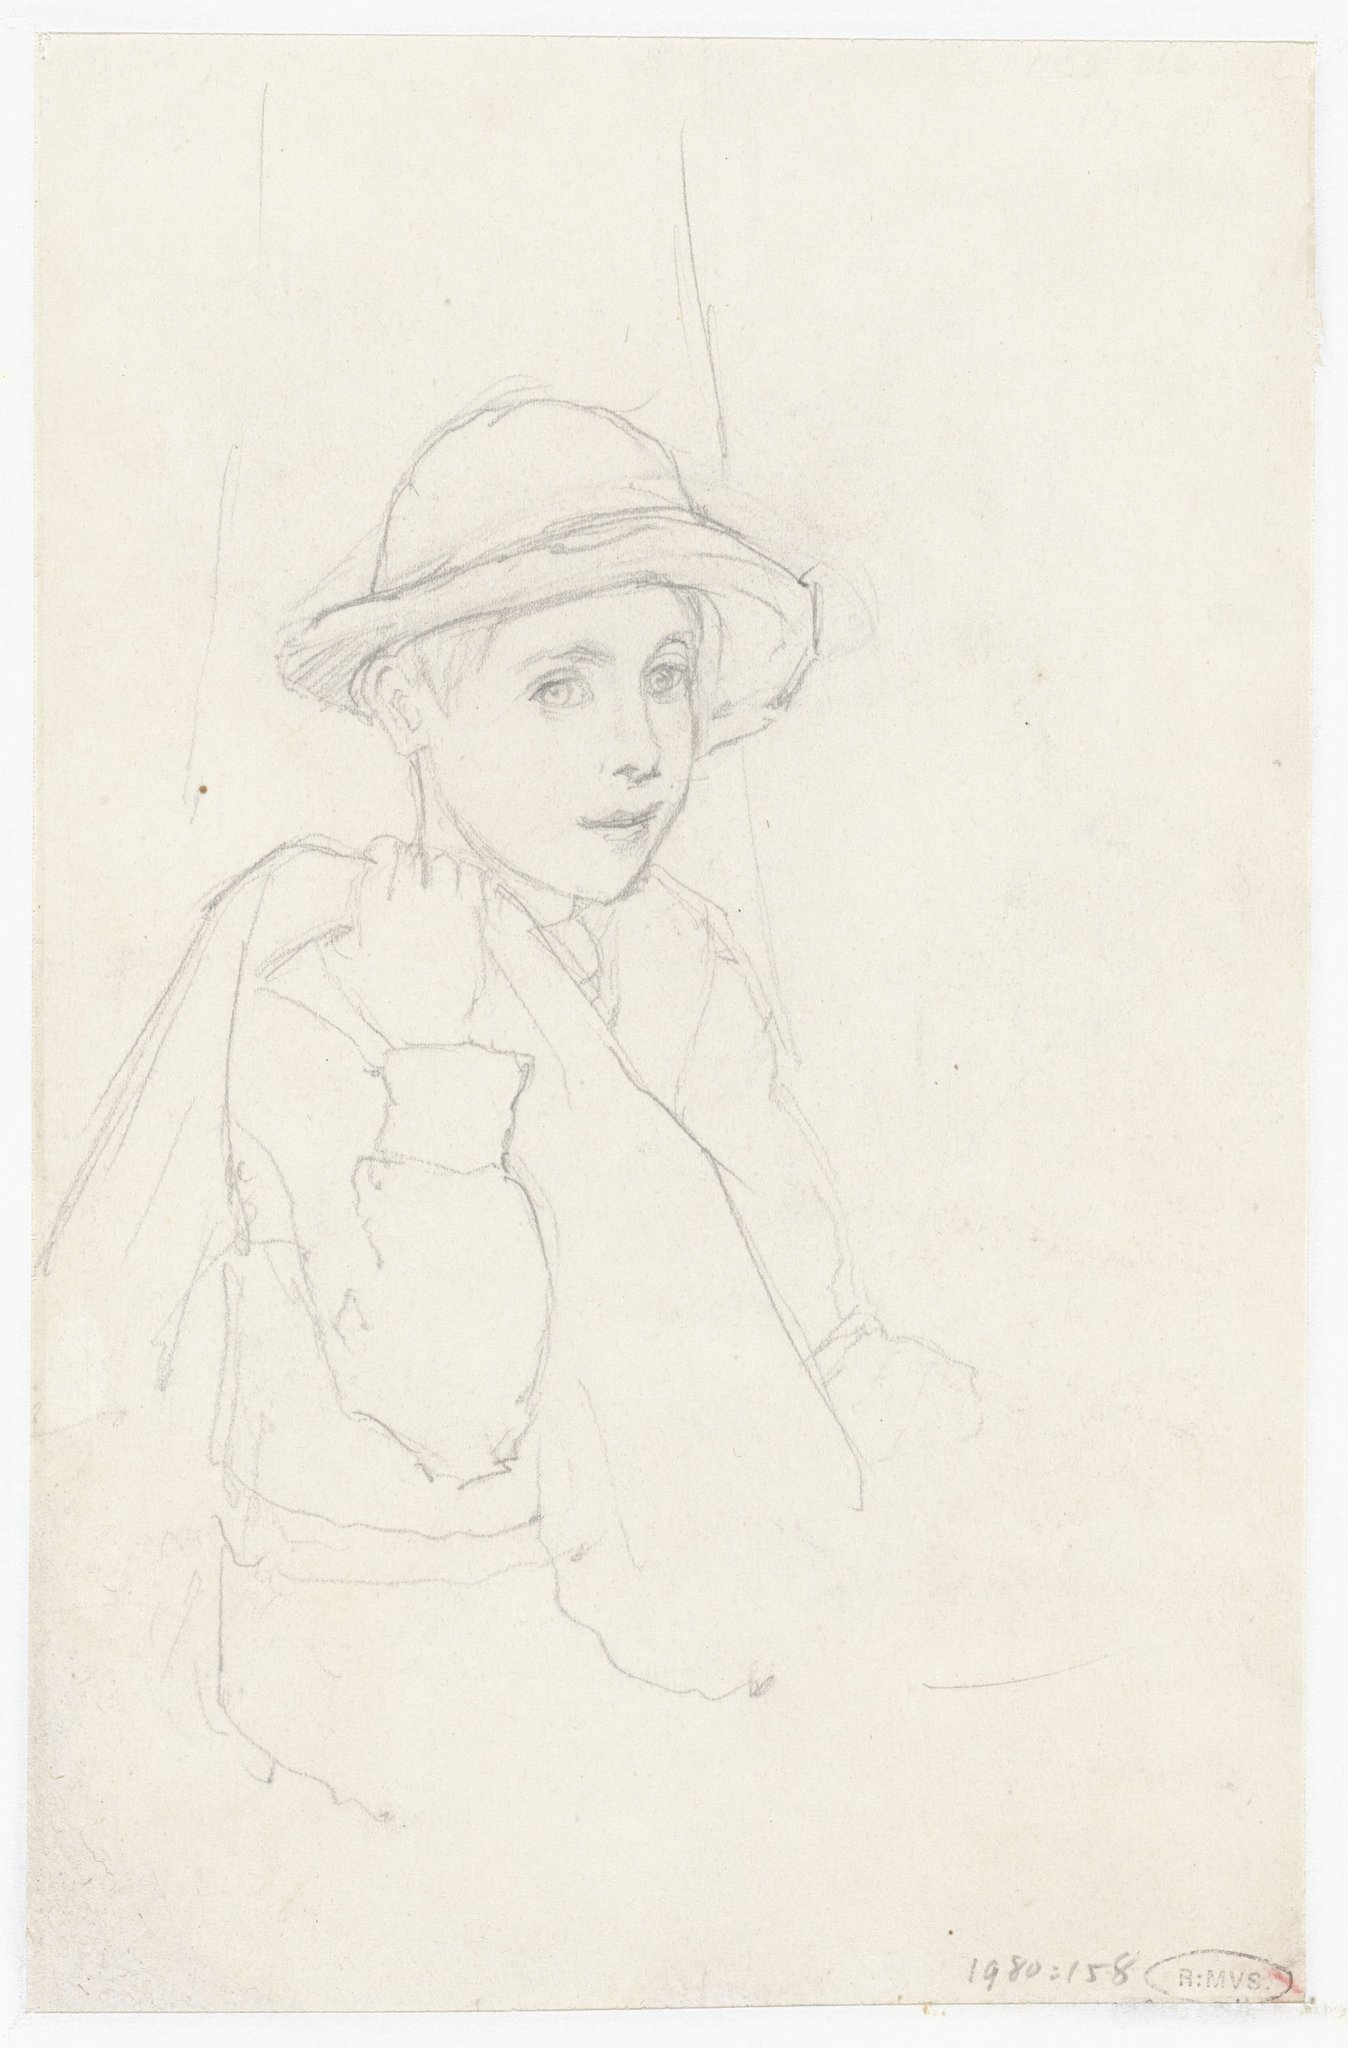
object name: drawing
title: Jongetje met een hoed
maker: jozef israëls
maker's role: draughtsman, painter, print maker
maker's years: 1824-1911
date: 1834-1911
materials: paper, pencil